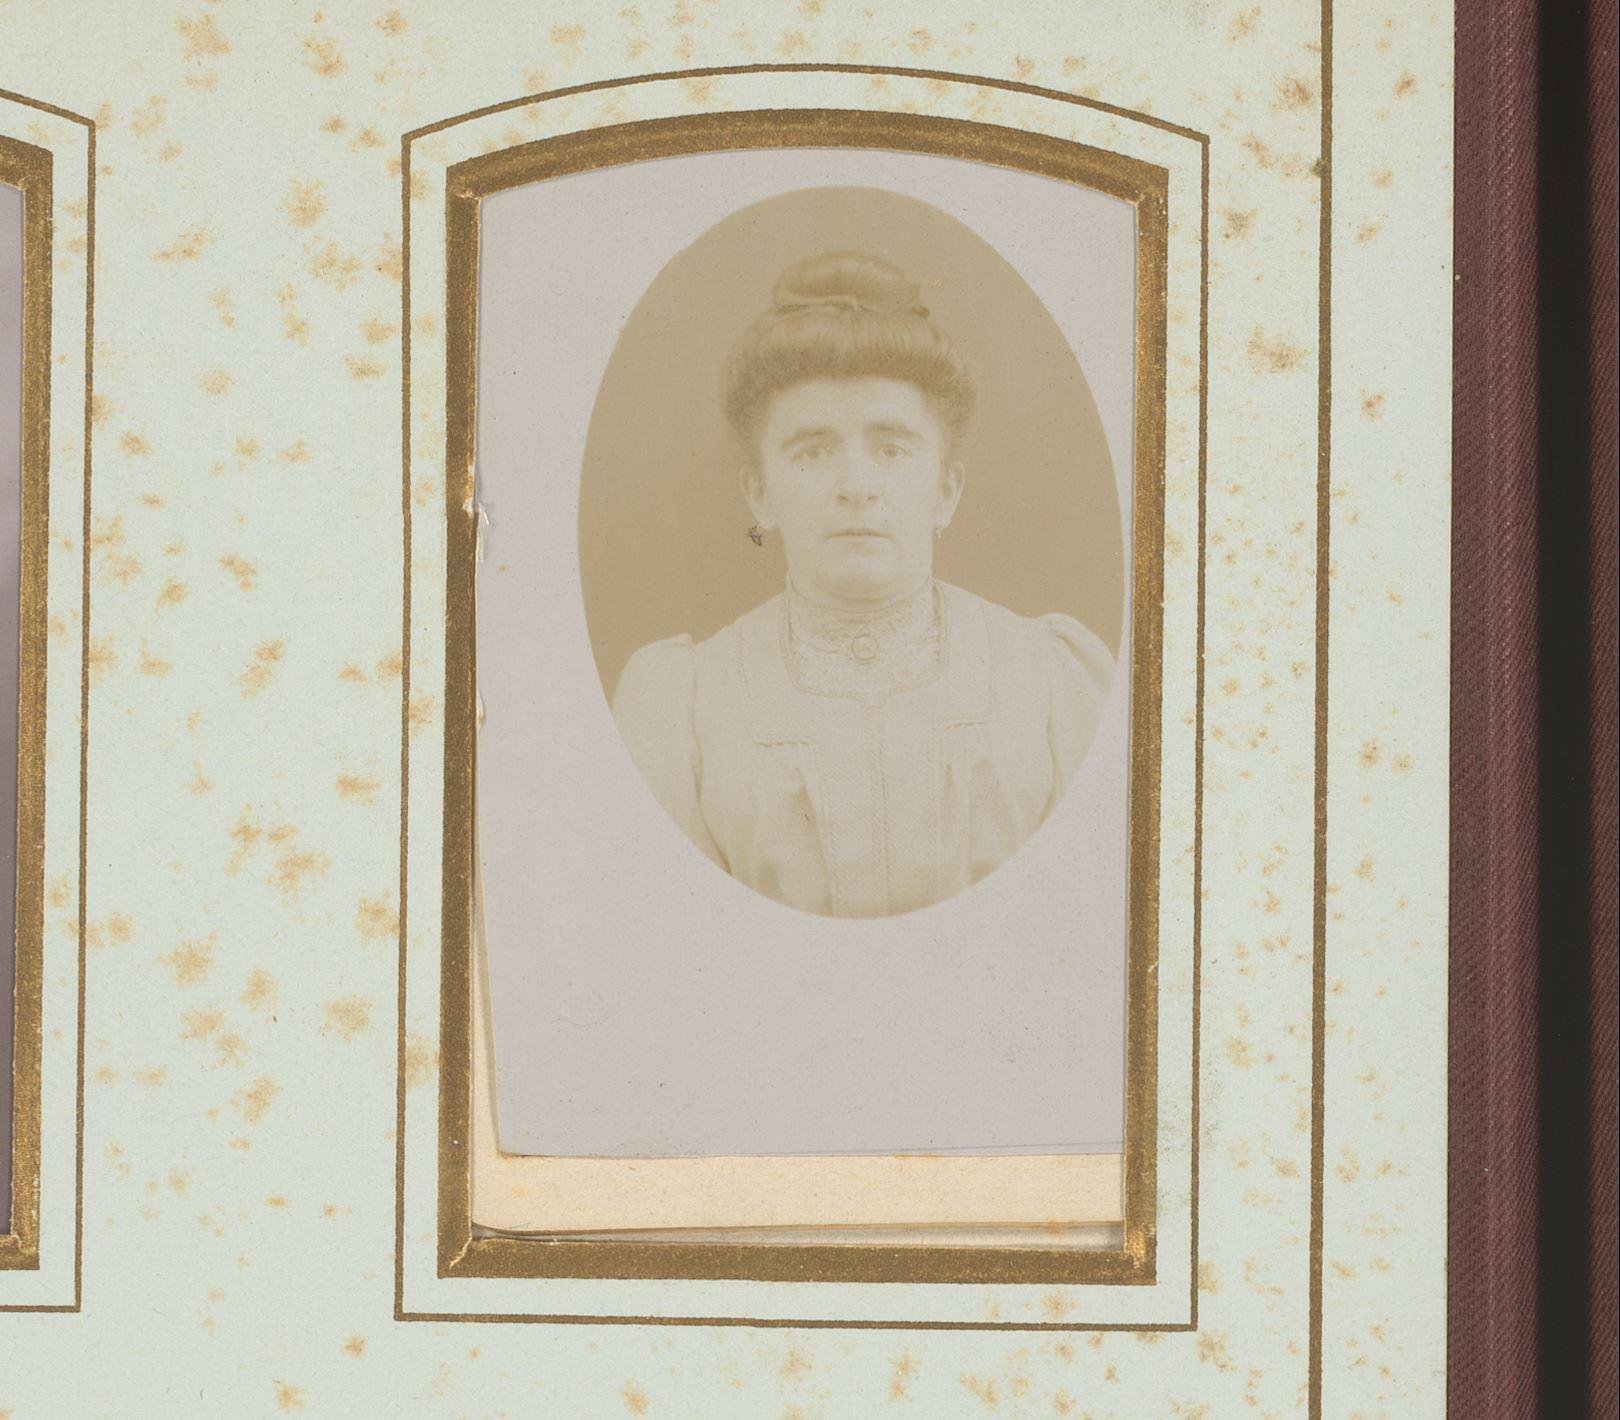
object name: carte de visite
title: Portret van een vrouw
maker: Anonymous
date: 1880-1920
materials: cardboard, photographic support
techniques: gelatin silver print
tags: historical persons - bb - woman